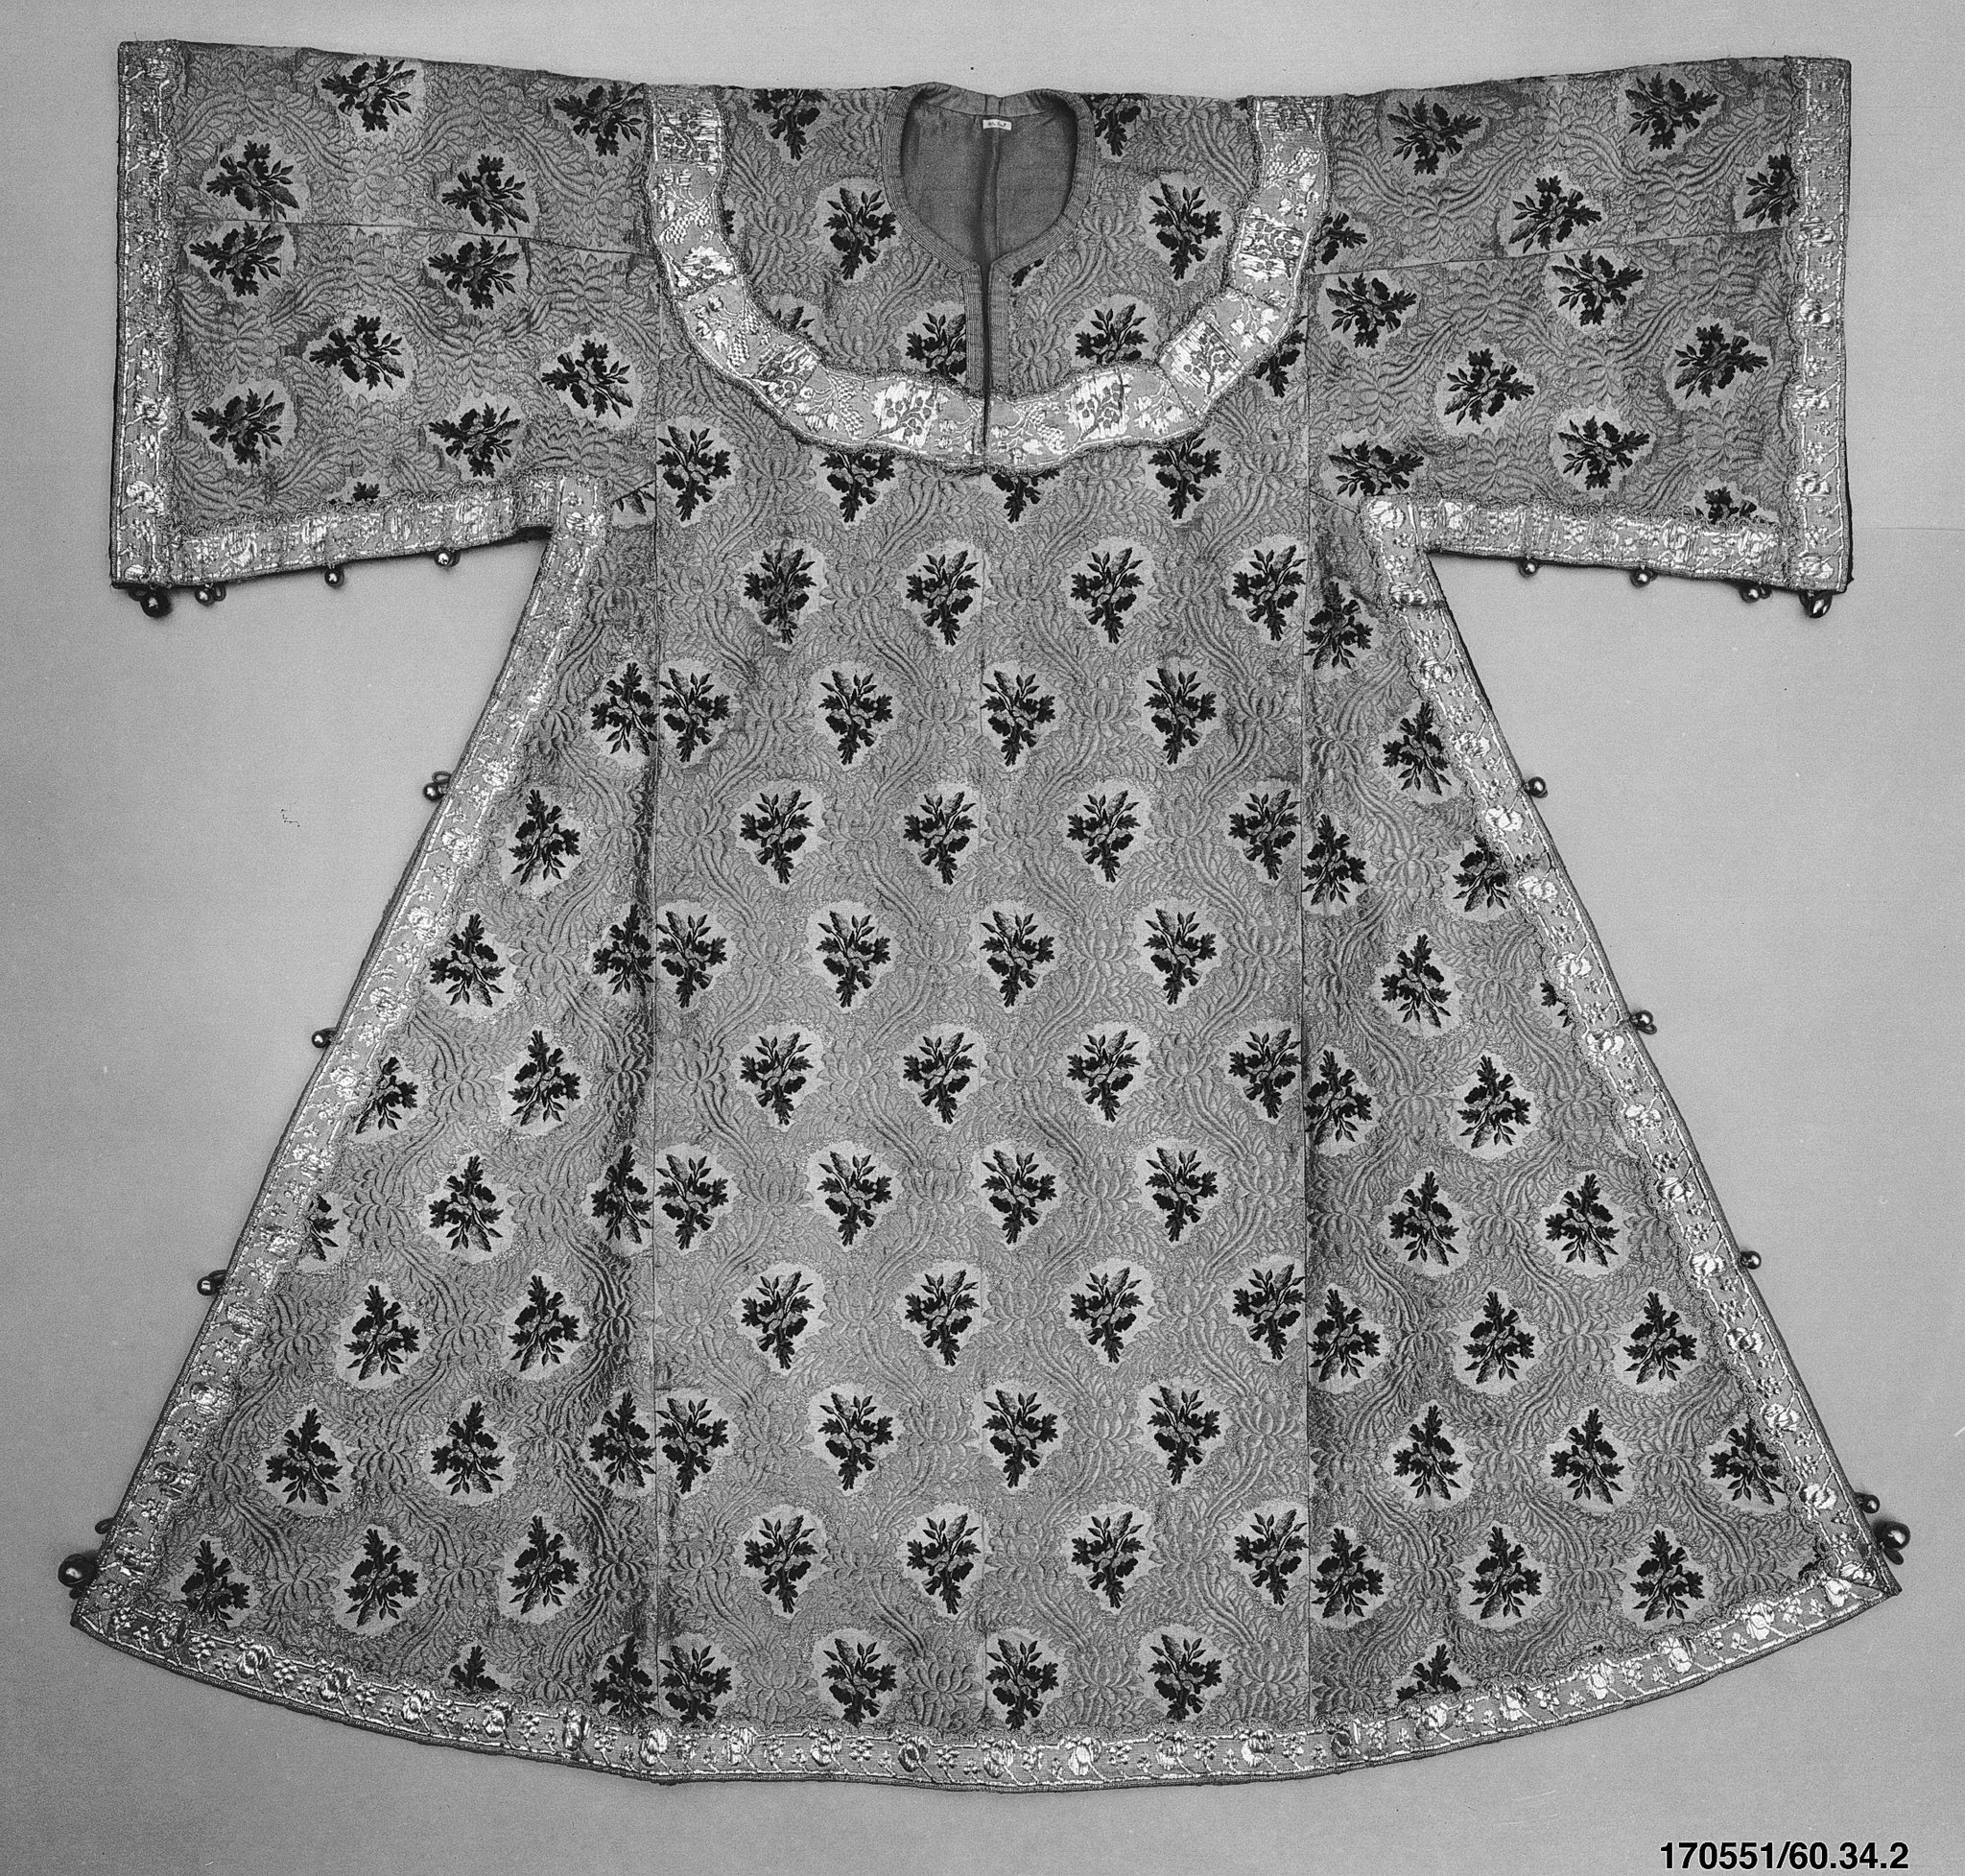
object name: sacco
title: Saccos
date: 1802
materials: metal thread, silk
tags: flowers